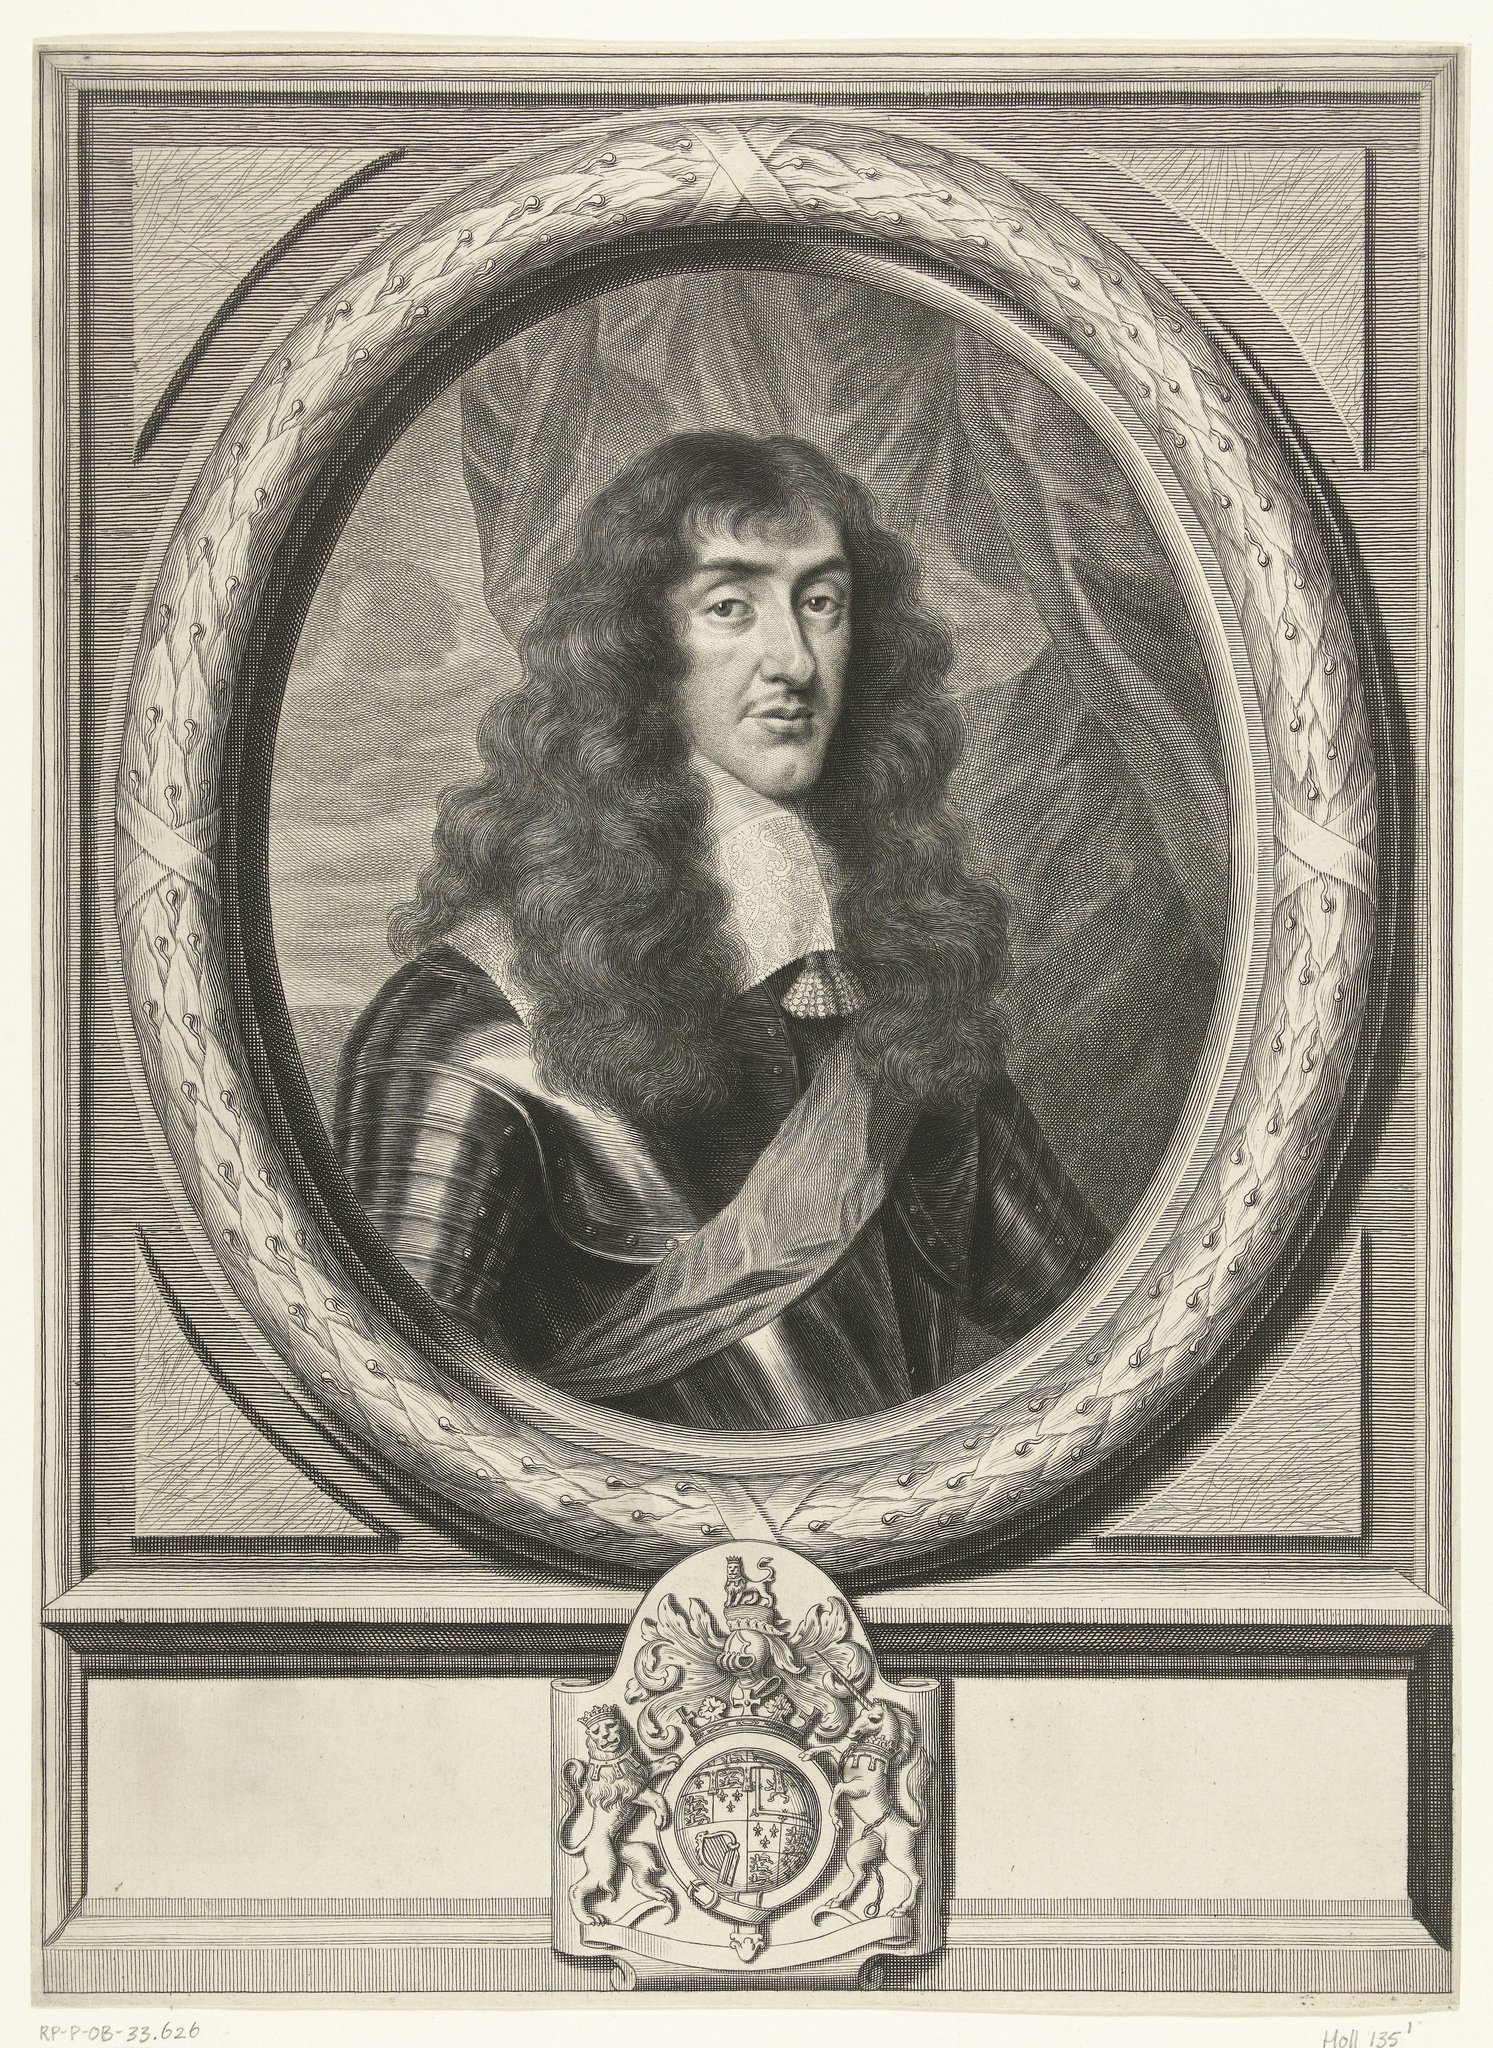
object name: print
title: Portret van James Stuart, hertog van York en Albanië, in ovale omlijsting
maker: cornelis van dalen (ii)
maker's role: draughtsman, print maker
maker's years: 1638-1664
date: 1648-1664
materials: paper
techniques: engraving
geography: amsterdam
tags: james stuart (hertog van york)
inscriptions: collector's mark: Lugt 2228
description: Prent naar schilderij van Simon Luttichuys. Hollstein beschrijft onder de nummers 135 en 136 twee portretten van James Stuart maar als we de drukken in de collectie van het RMA naast elkaar leggen dan wordt duidelijk dat het om één drukplaat gaat welke in vier verschillende staten is gewijzigd. Veranderingen werden aangebracht in het portret, vergelijk de kraag en haardracht op de eerste staat met de overige drie staten, maar ook het wapen en opschrift ondergingen wijzigingen.